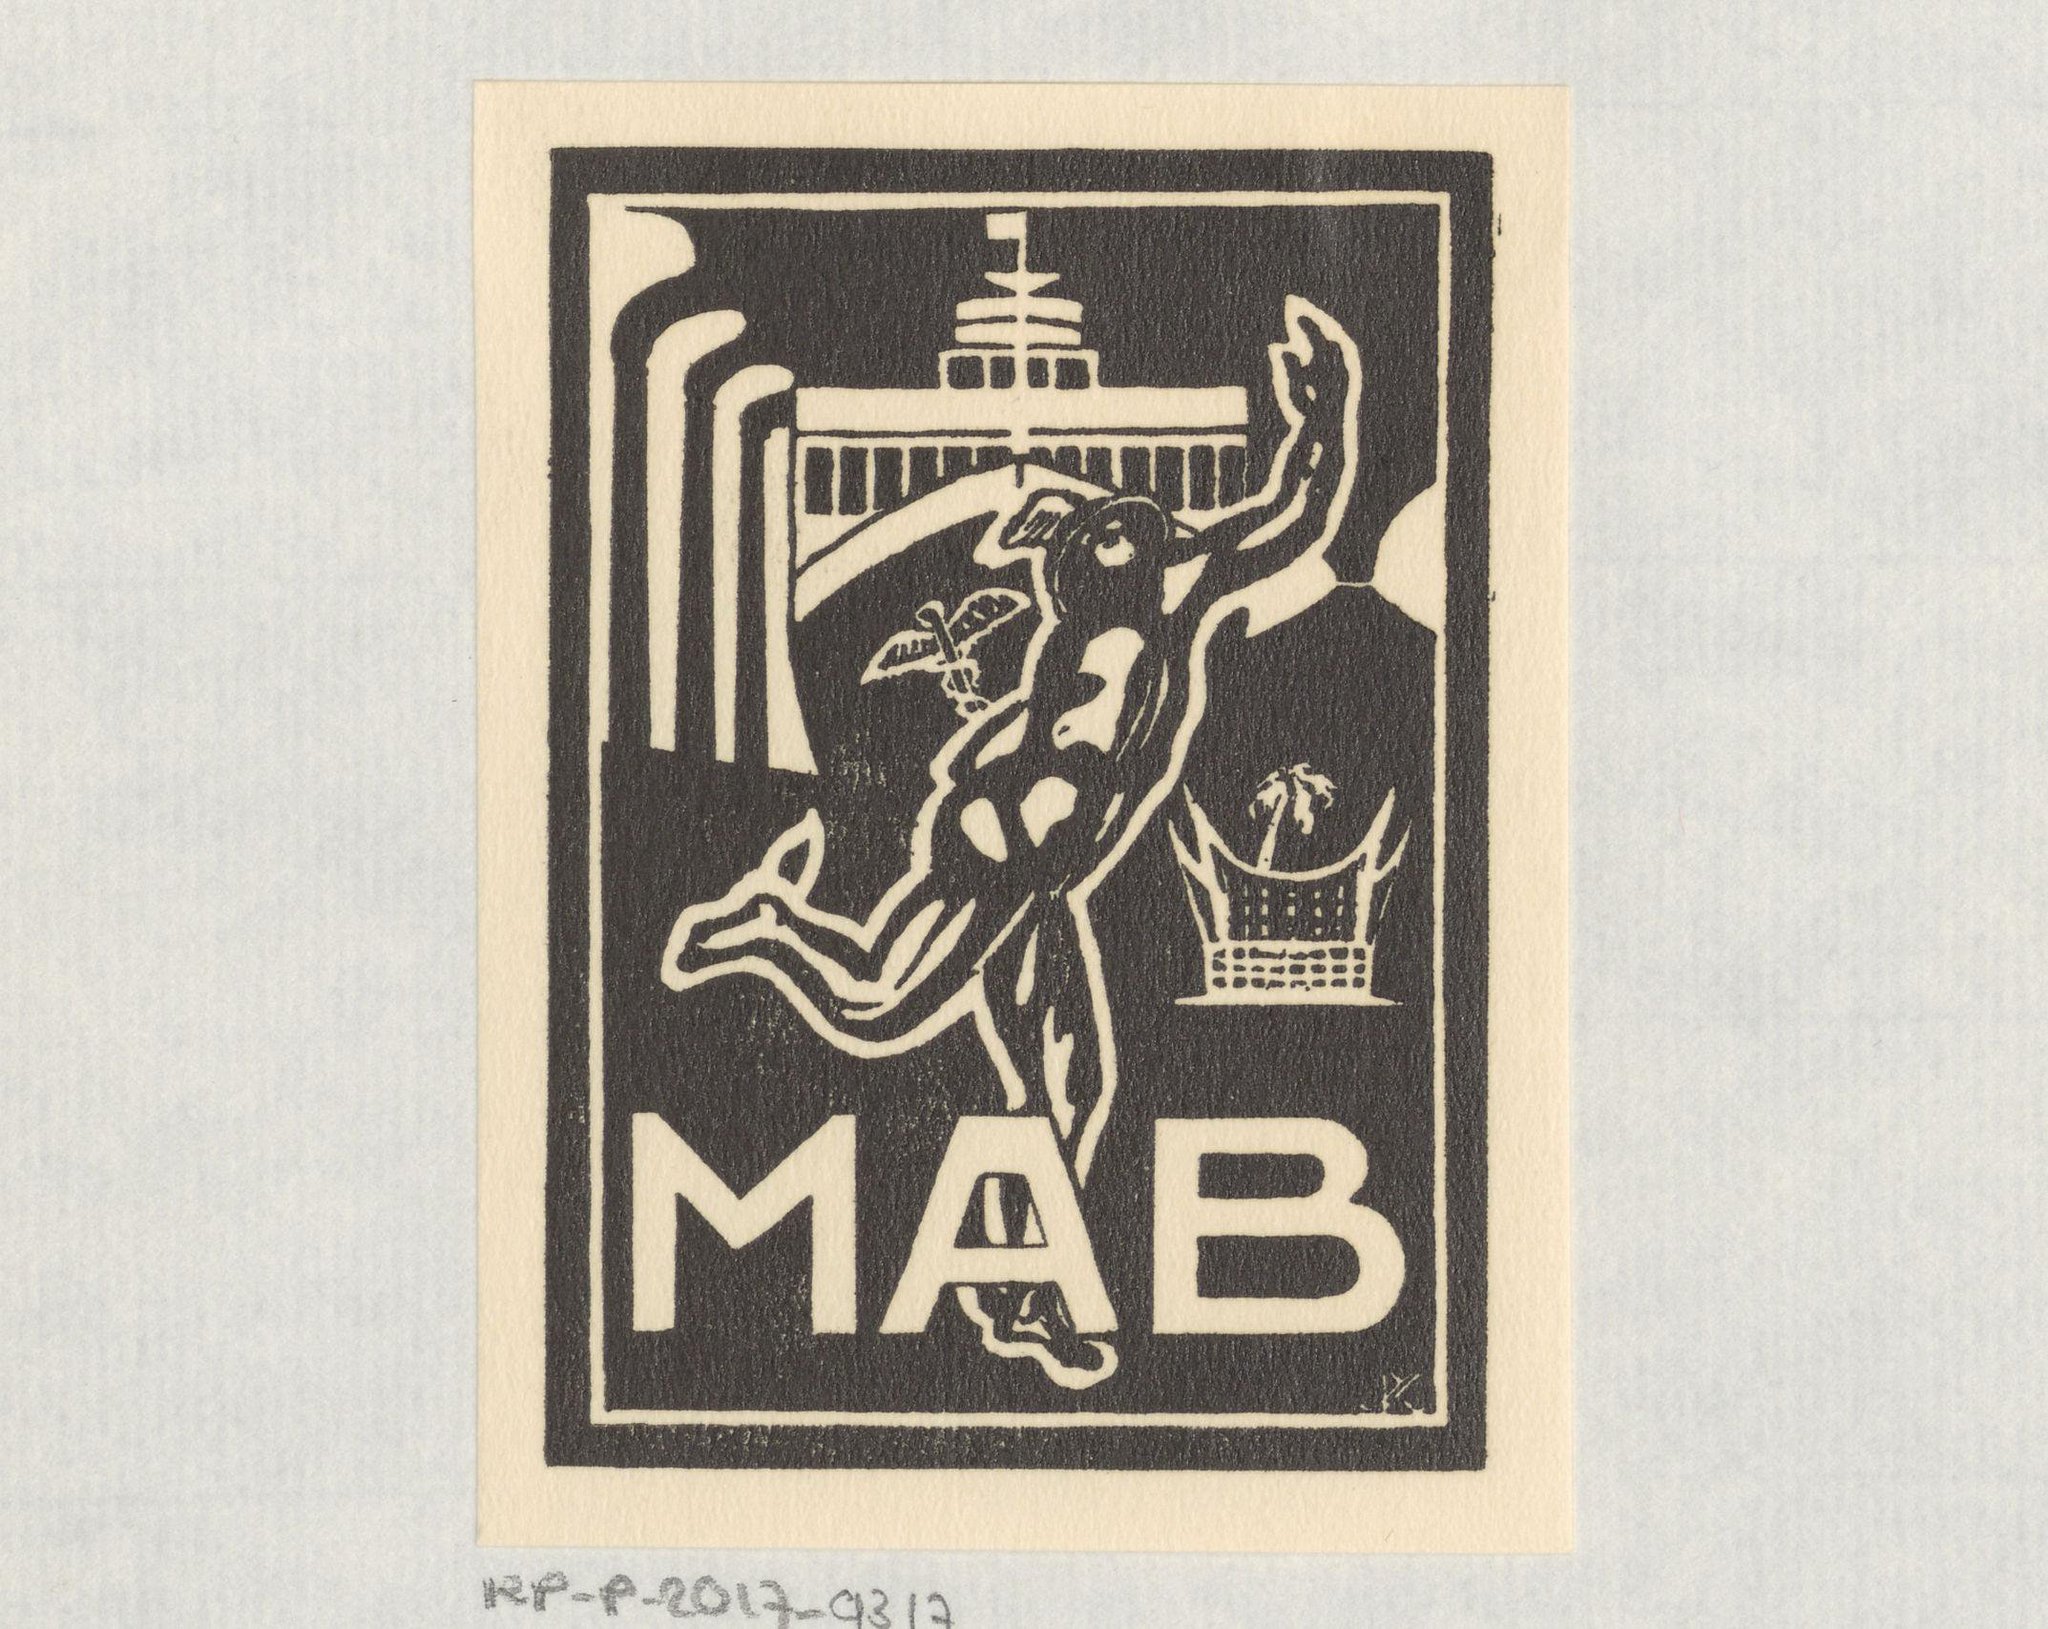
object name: bookplate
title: Ex libris van M.A.B.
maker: Anonymous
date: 1900-1999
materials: paper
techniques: linocut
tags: (story of) mercury (hermes), traffic on the water